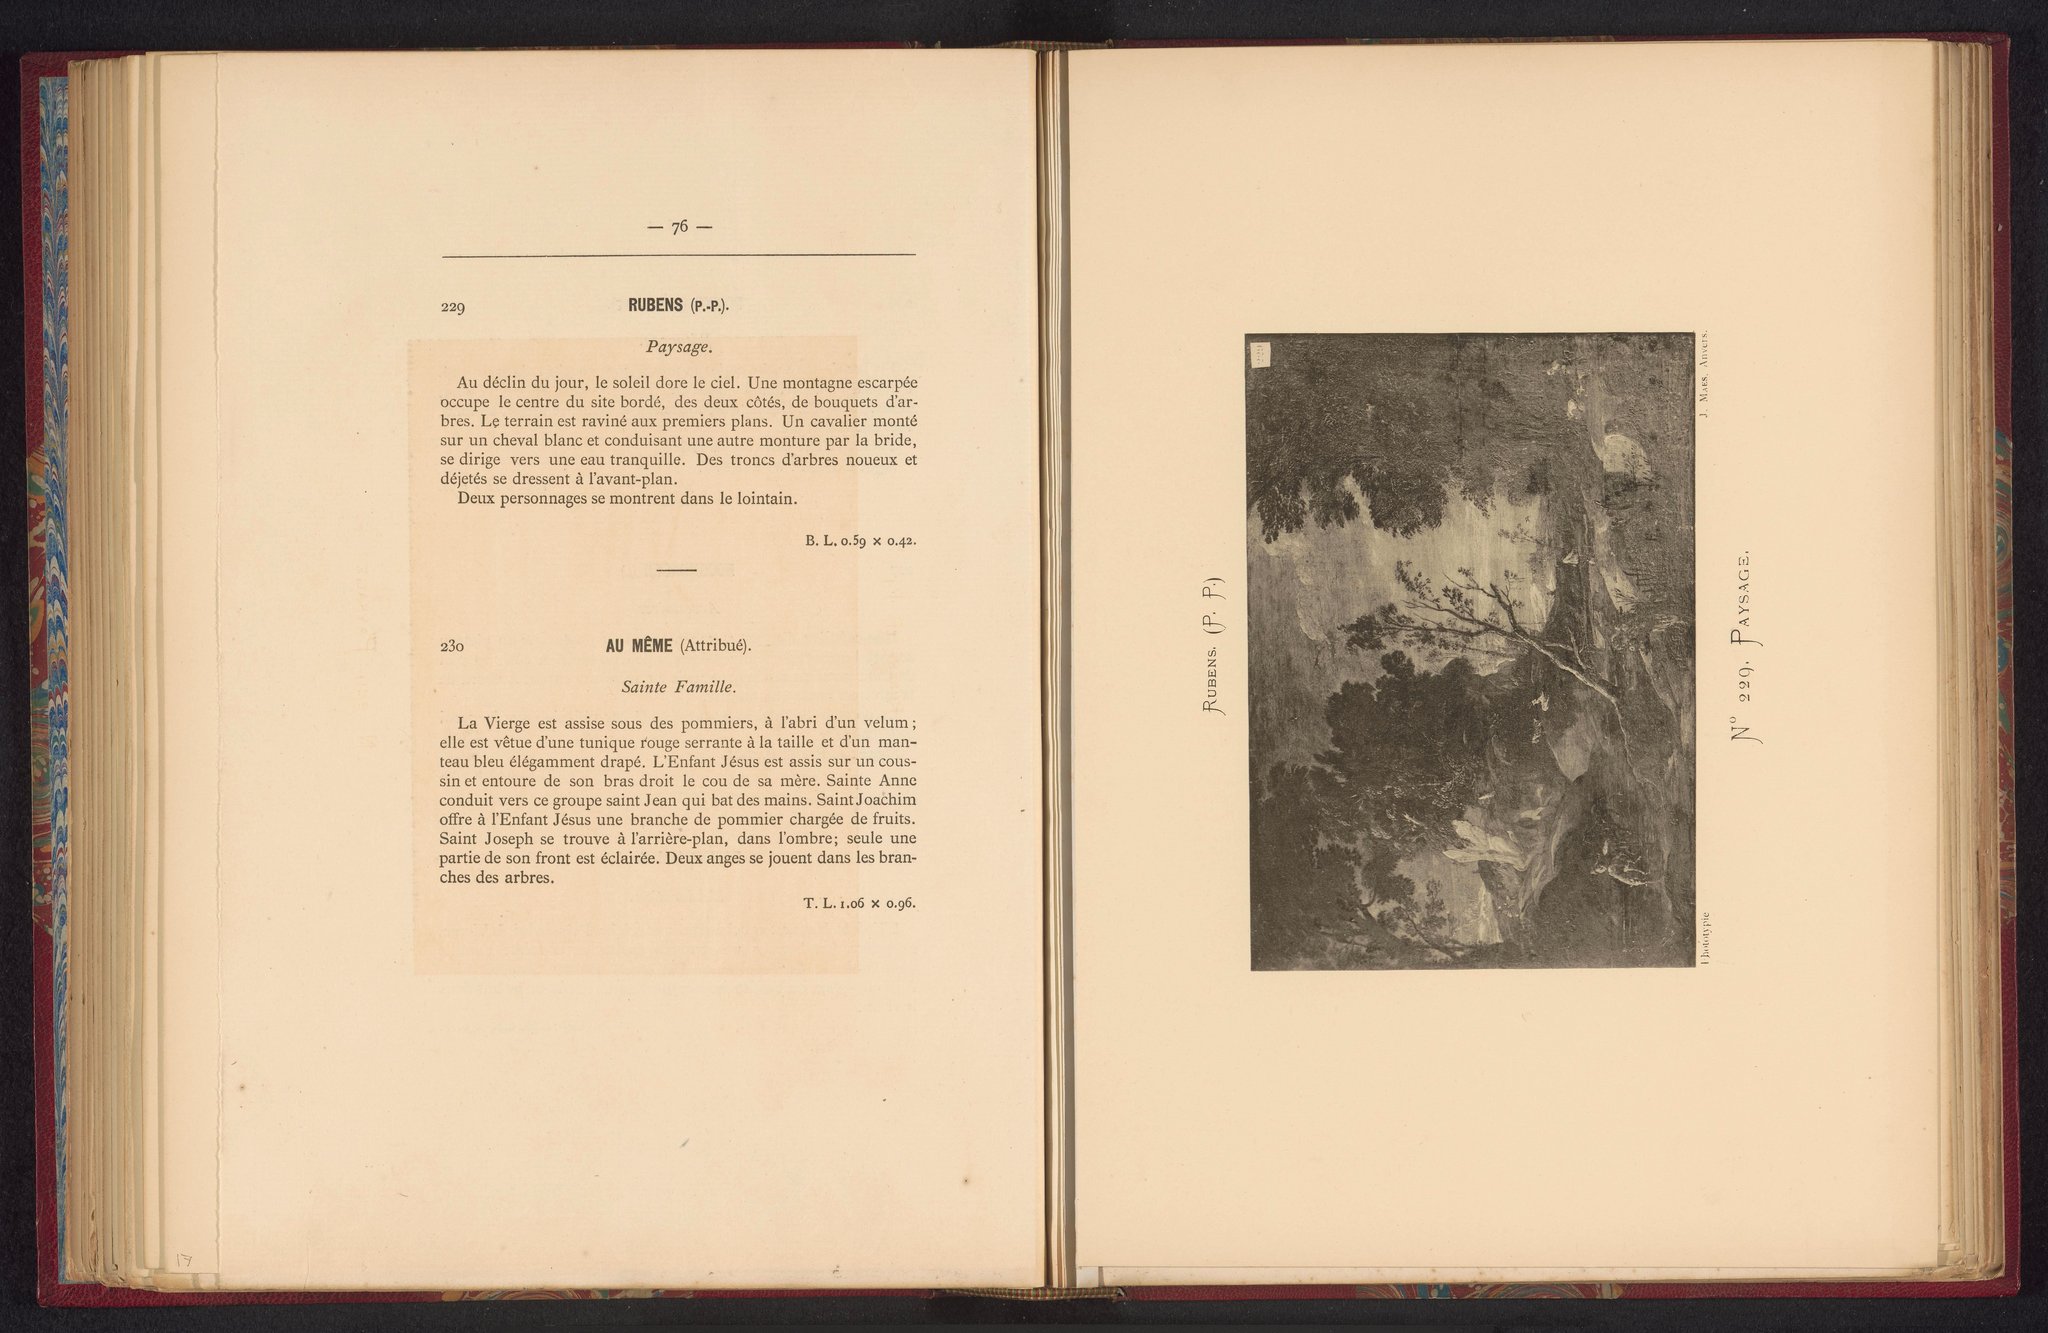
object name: photomechanical print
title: Rubens, P.P. - Paysage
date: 1878-1883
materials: paper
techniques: photograph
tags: landscapes, painting, drawing and the graphic arts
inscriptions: number: ‘No. 229’